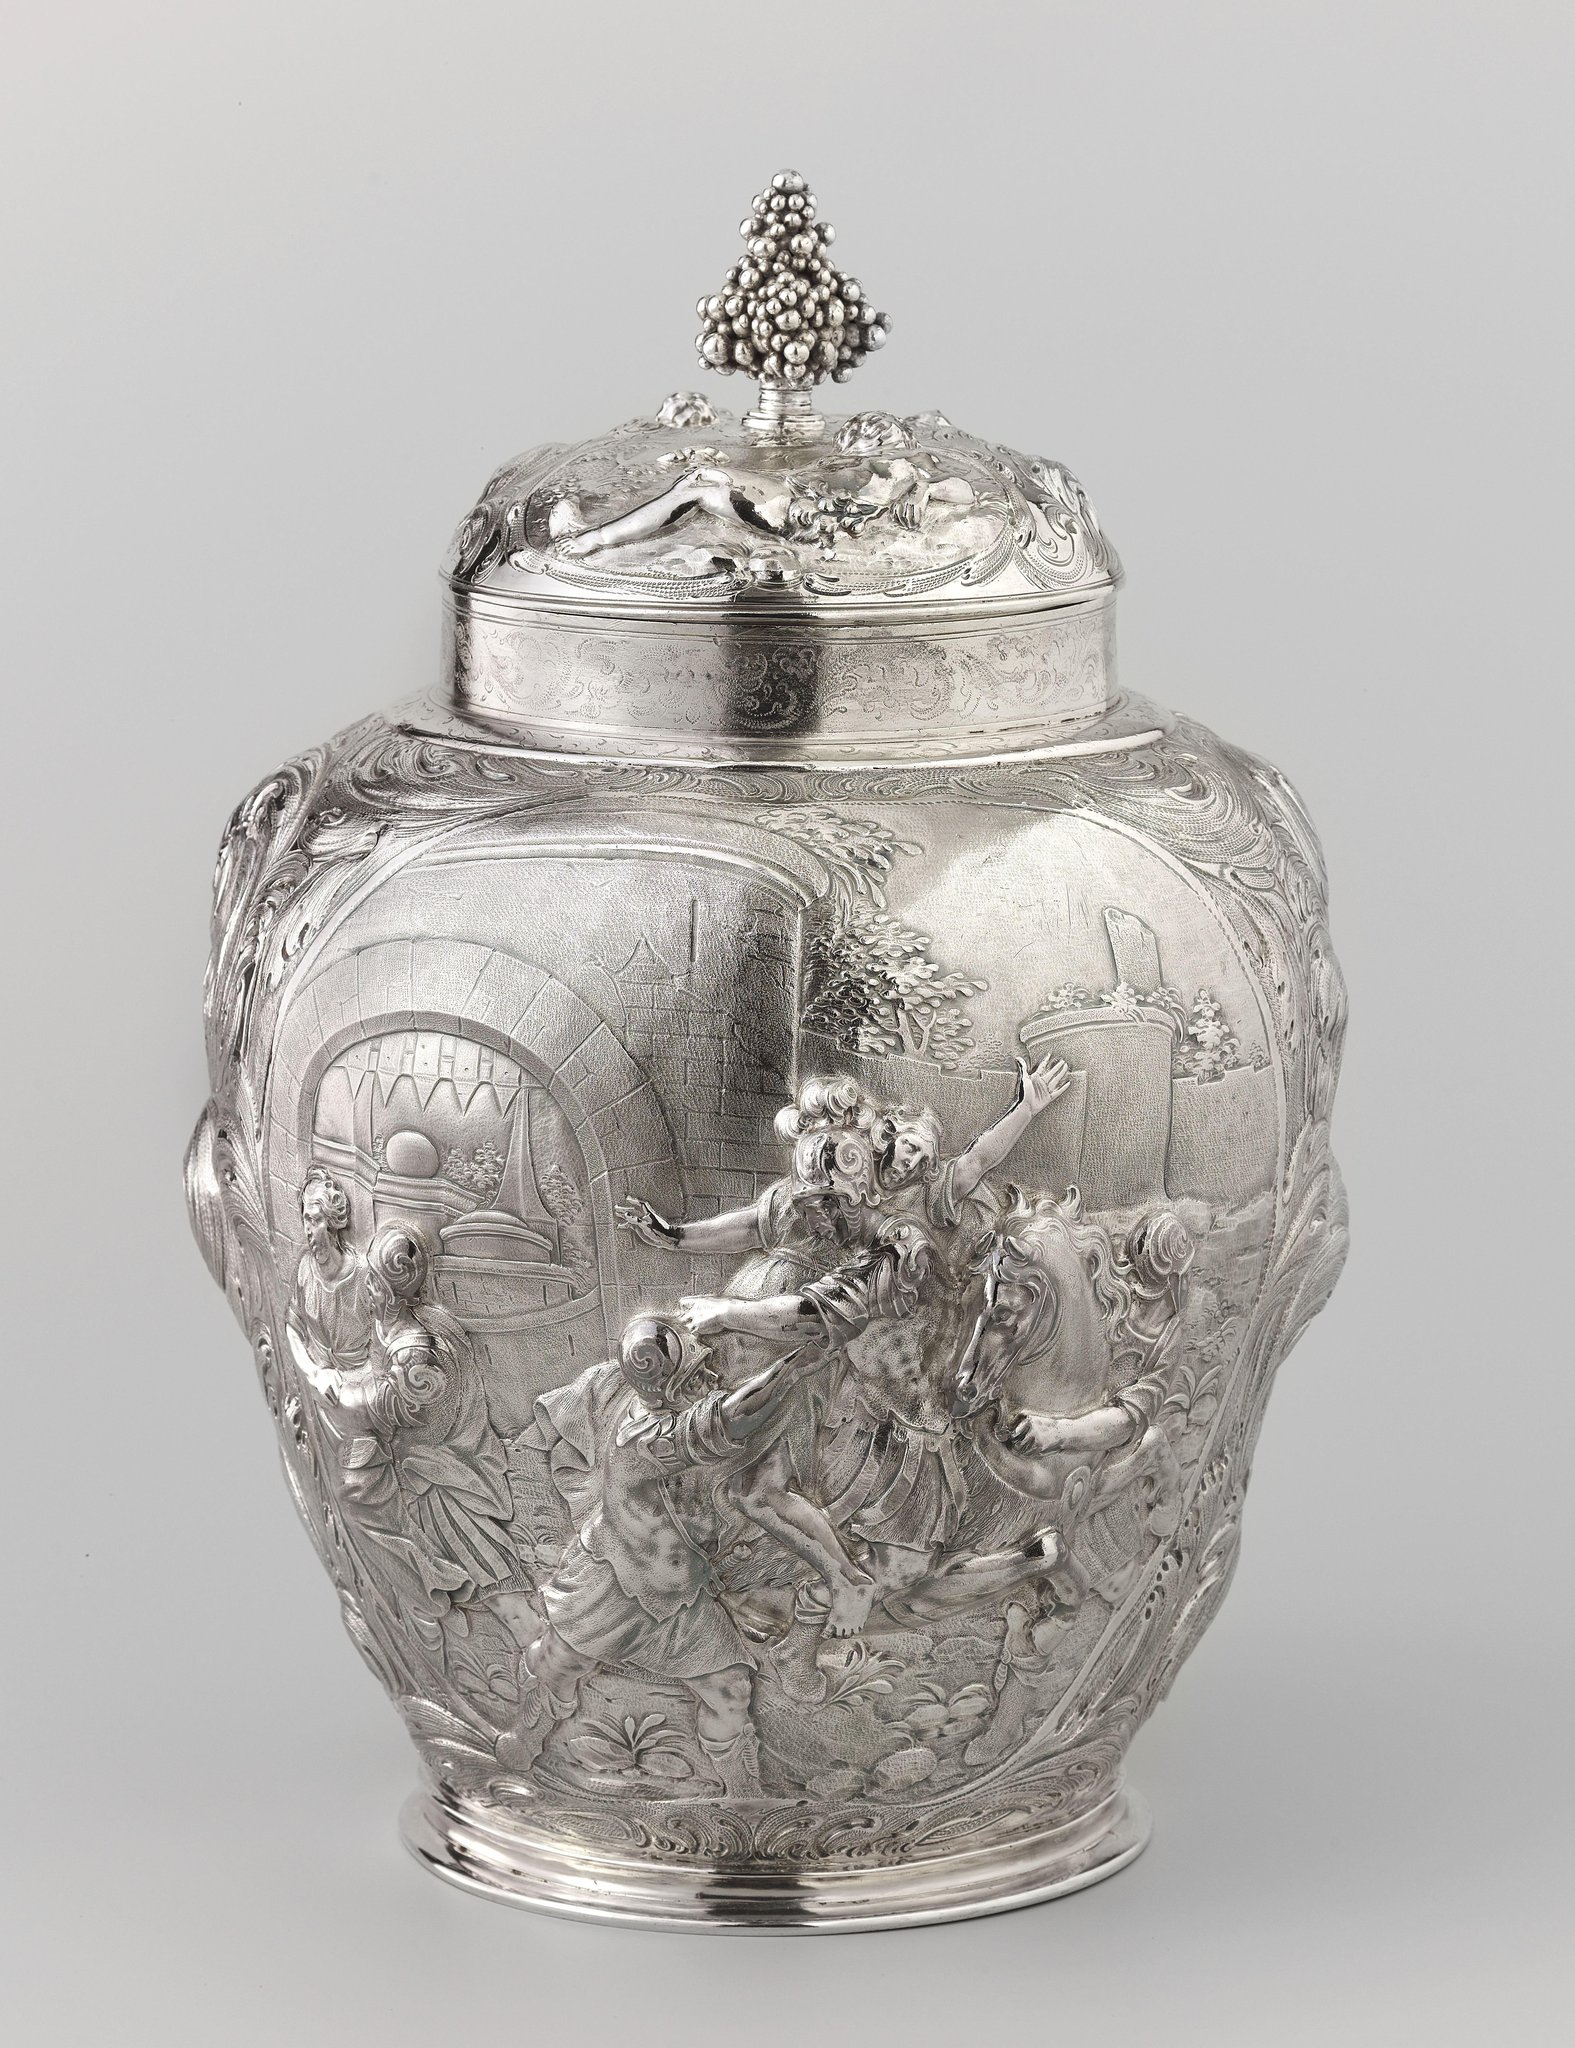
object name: covered jar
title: Lidded vase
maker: Anonymous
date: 1670-1680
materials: silver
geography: england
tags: rape of the sabine women: they are carried off by romulus and his men during a feast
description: Pot van zilver, met deksel. Aan weerszijden in hoog reliëf gedreven, respectievelijk Mars en Venus en de Sabijnse Maagdenroof.